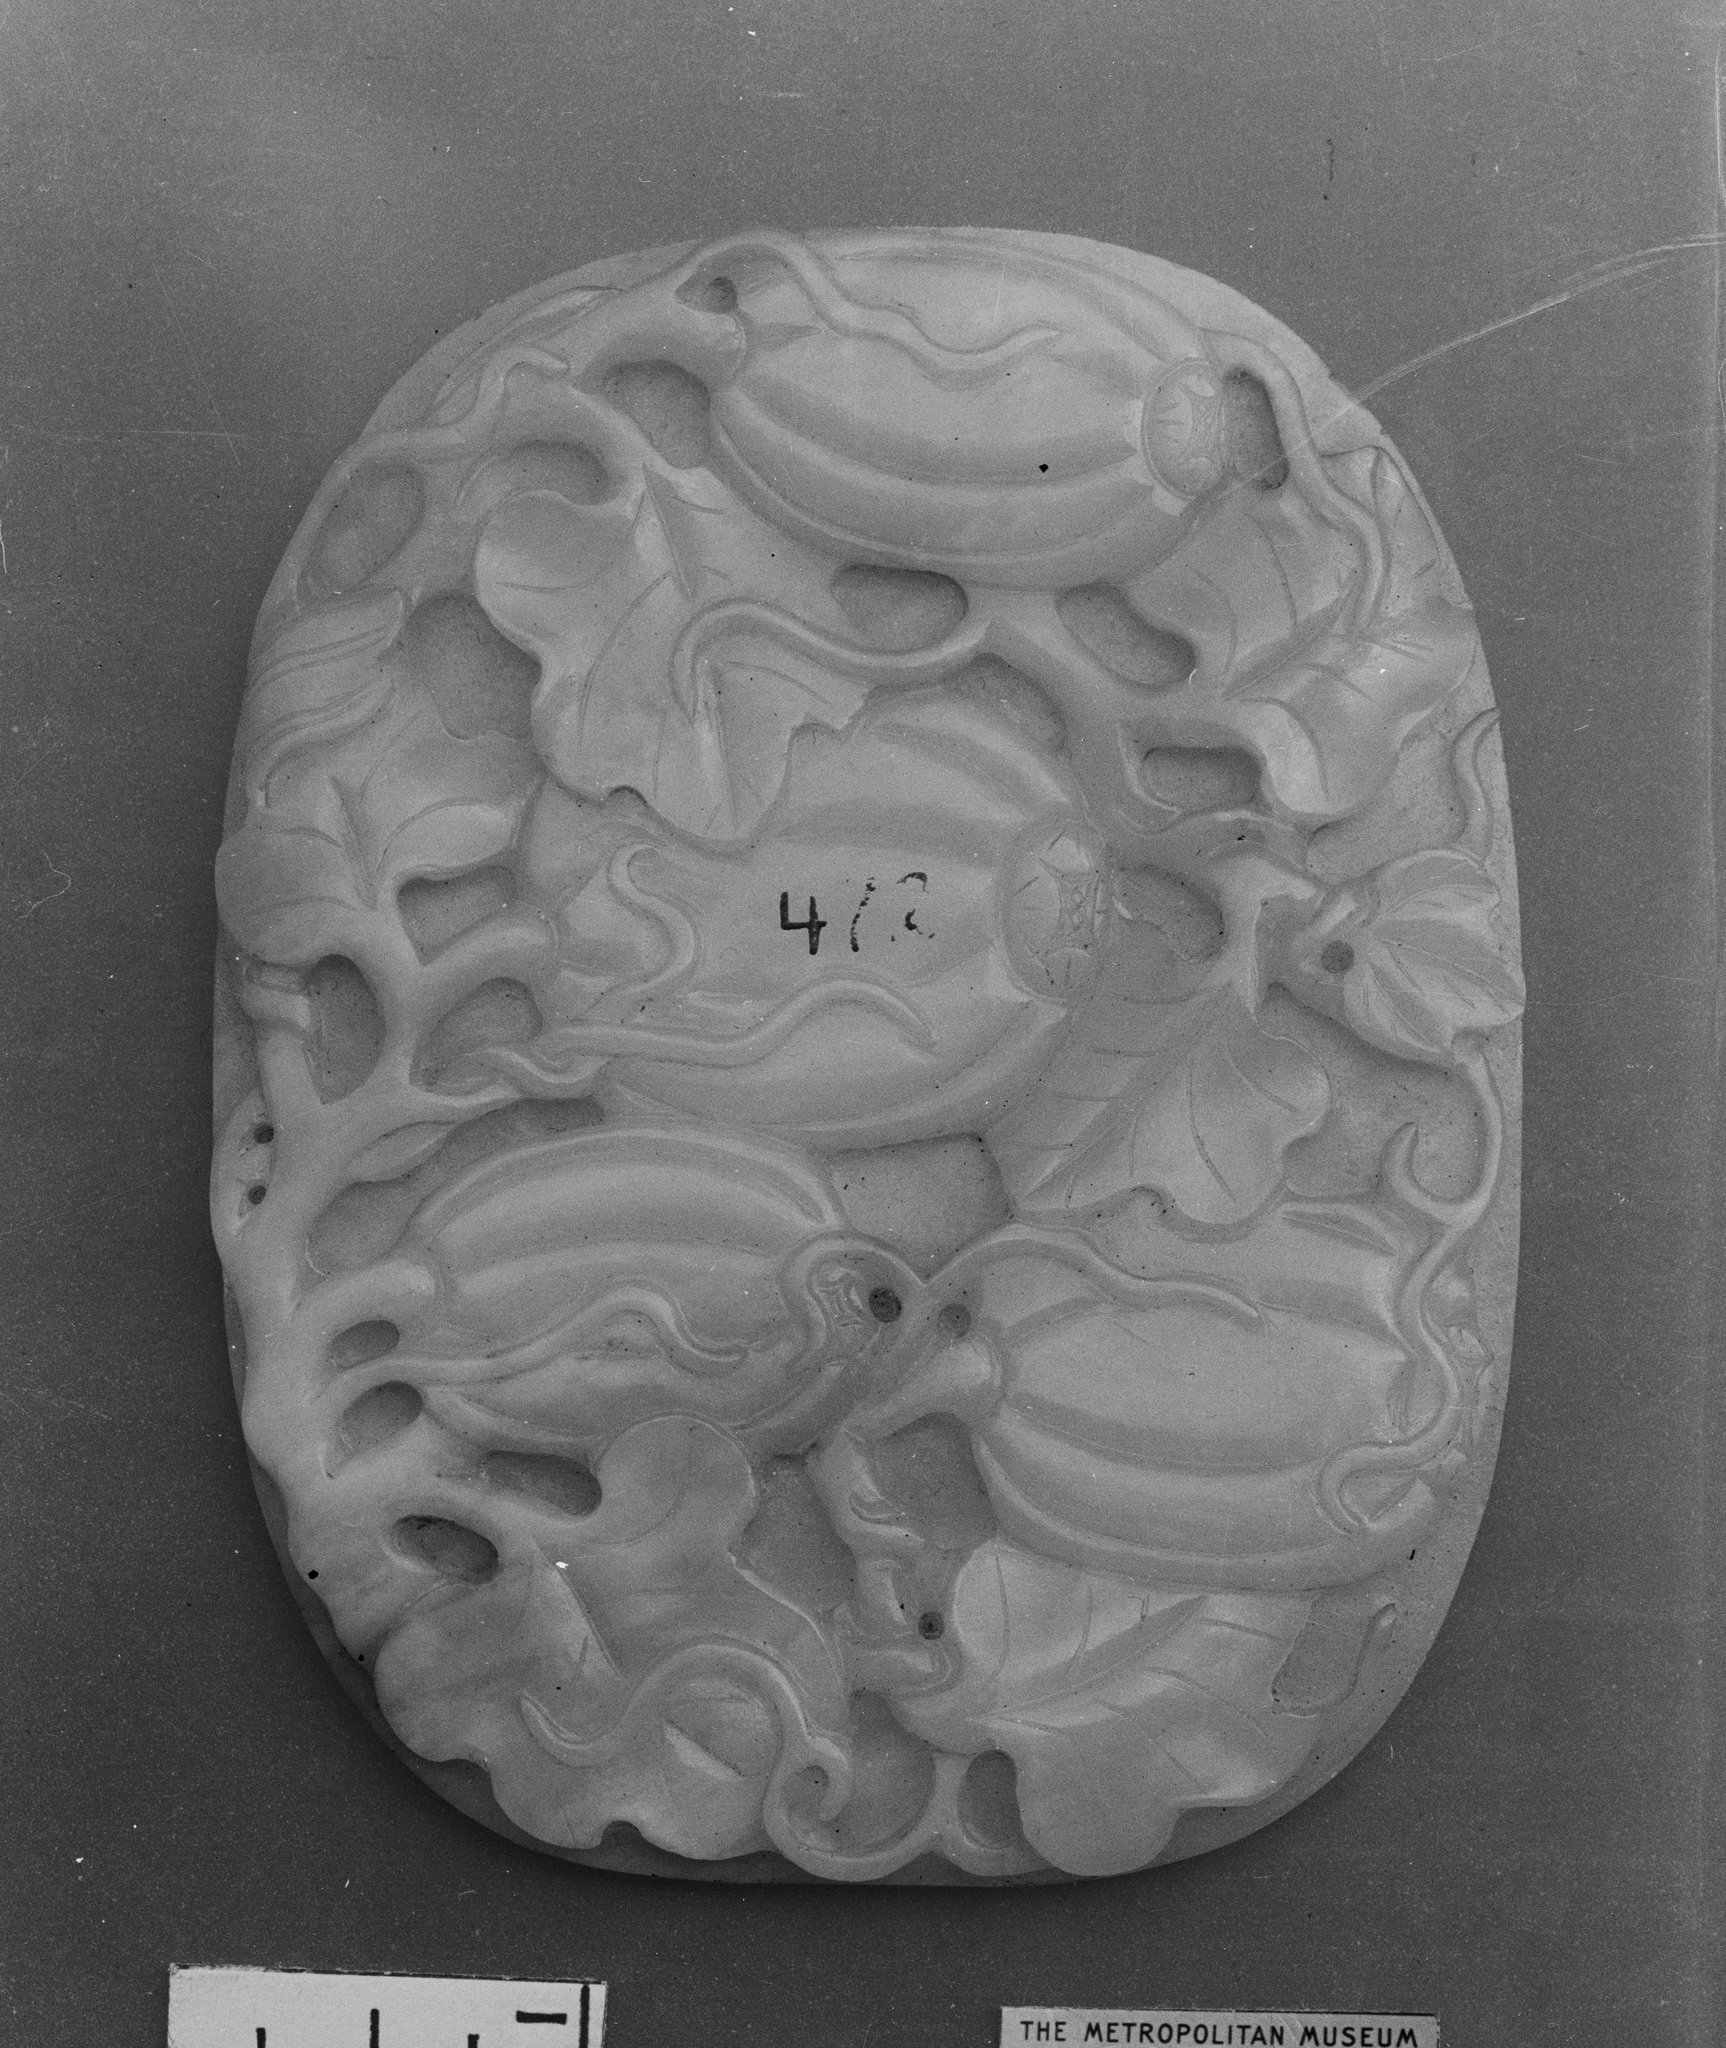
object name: plaque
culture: chinese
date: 1662-1722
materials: jade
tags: leaves